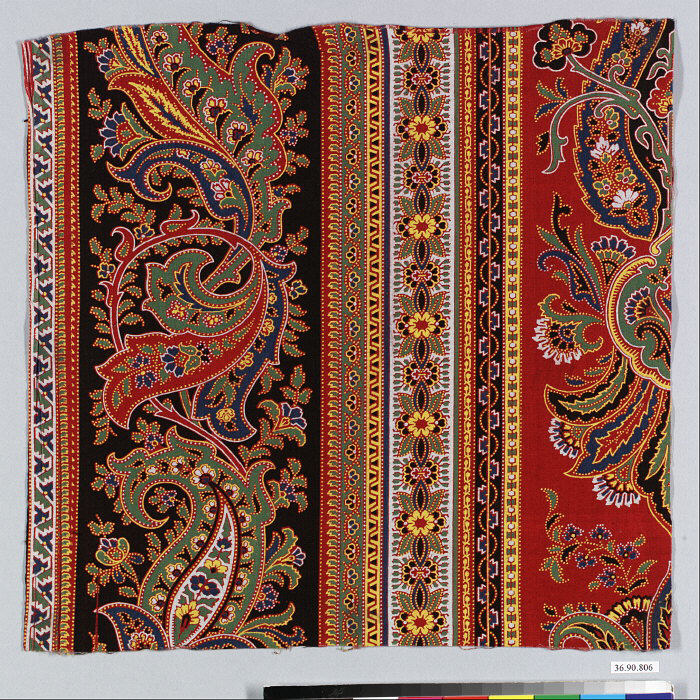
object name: piece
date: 1867-1900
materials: cotton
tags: flowers